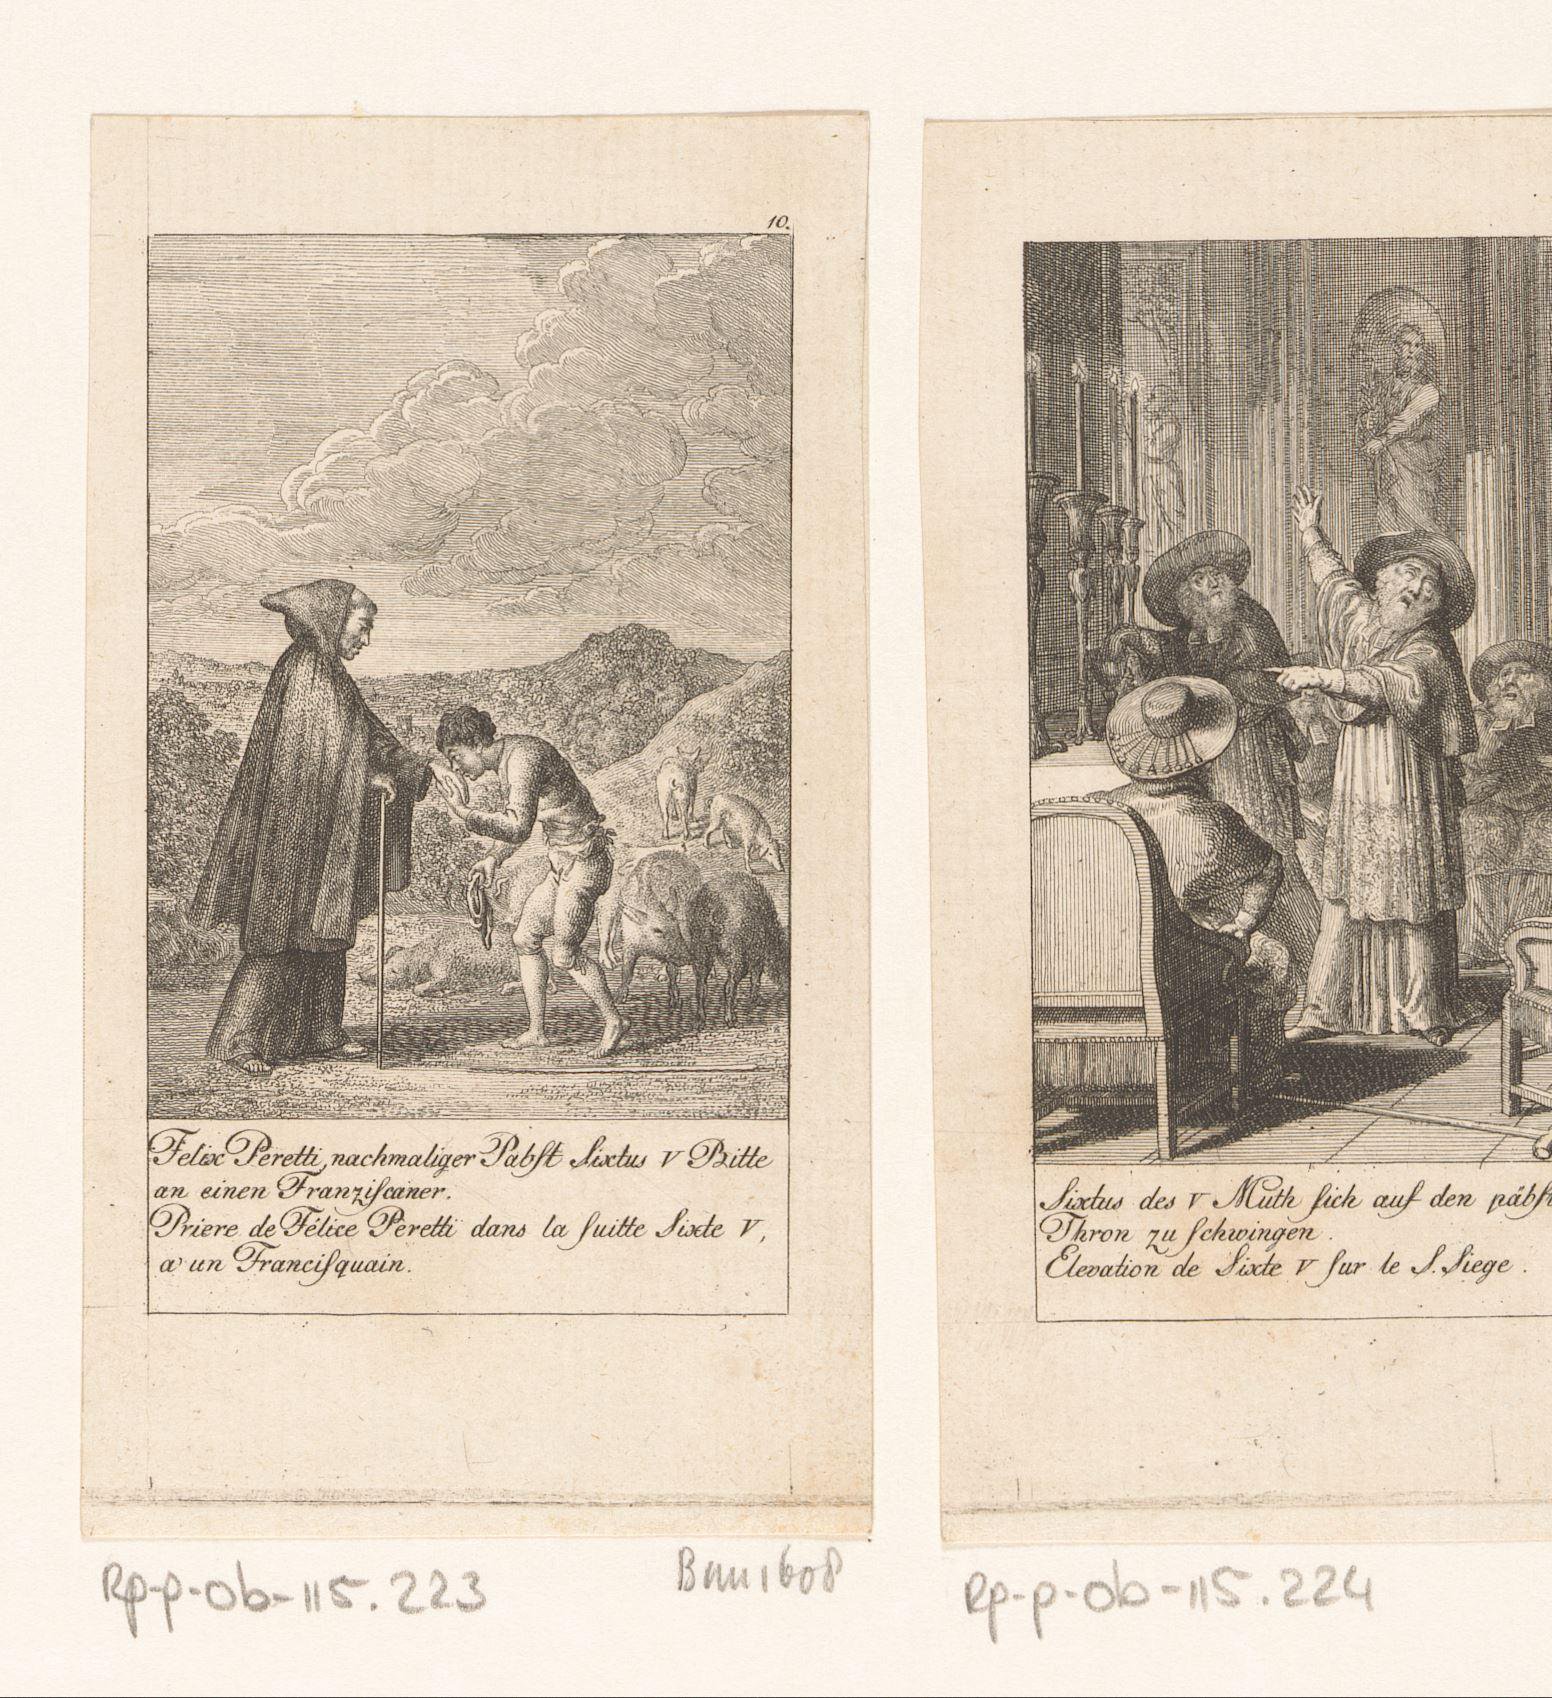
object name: print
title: Felix Perrettis buigt voor de franciscaner monnik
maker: daniel nikolaus chodowiecki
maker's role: draughtsman, print maker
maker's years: 1726-1801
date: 1792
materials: paper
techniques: etching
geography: berlin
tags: rome, sixtus v, boar (male pig), history, head bent forward; bowing, monastic orders, monastic life: franciscans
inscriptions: collector's mark: Lugt 2228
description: Latere staat gebruikt voor: Almanac de Gotha pour l'anneé 1793. Gotha: C. W. Ettinger, [1792].